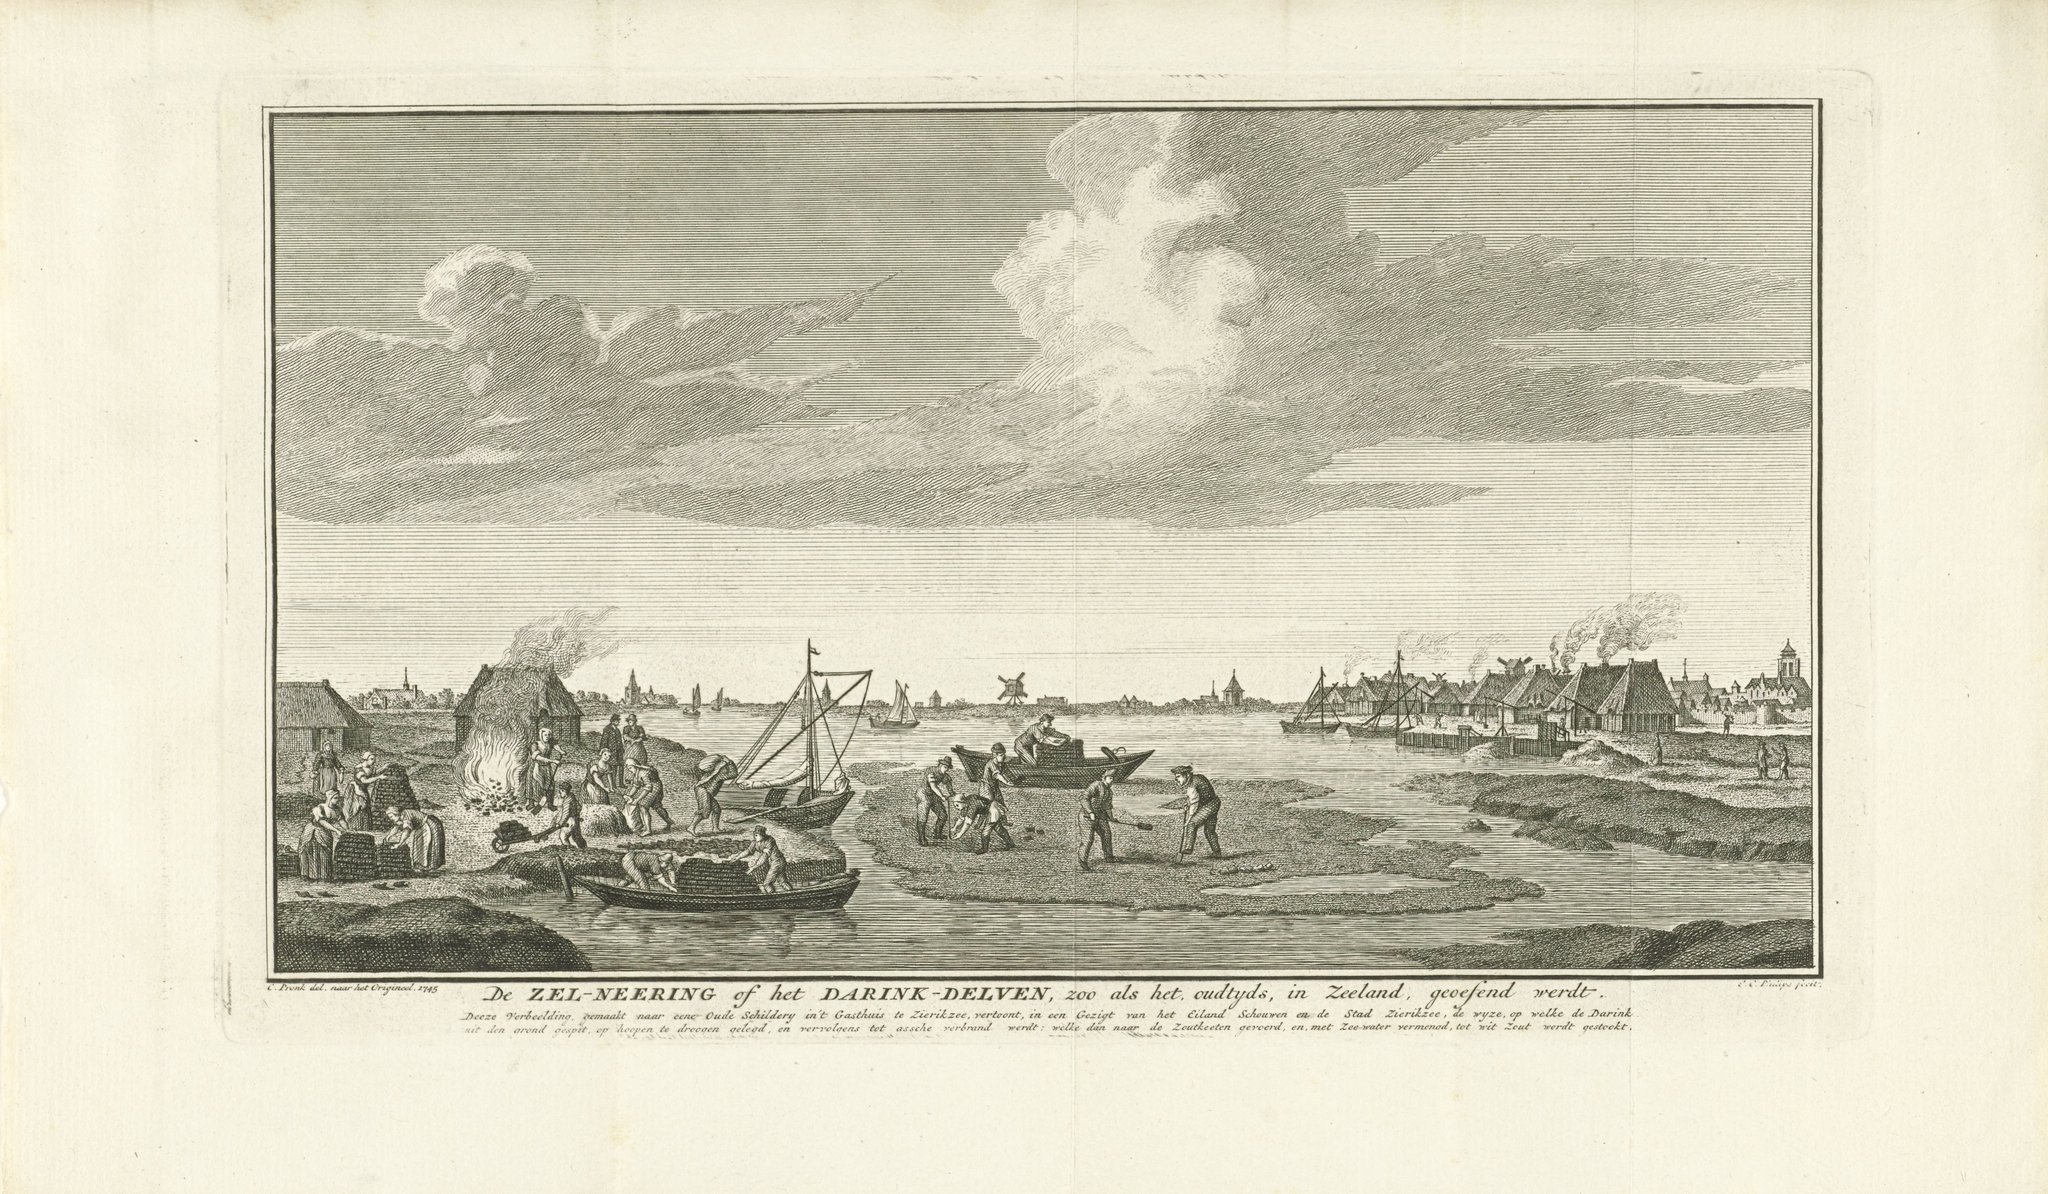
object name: print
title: De zel-neering of het darink-delven, zoo als het oudtyds, in Zeeland, geoefend werdt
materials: paper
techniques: engraving, etching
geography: amsterdam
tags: opencast mine; strip mining, salt, zeeland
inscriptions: collector's mark: Lugt 2228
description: Eerdere staat van prent ook gebruikt in: Wagenaar, Jan. Vaderlandsche historie, vervattende de geschiedenissen der Vereenigde Nederlanden […]. 21 delen. Amsterdam: Isaak Tirion, 1749-1759, dl. 4 (1750), p. 170. En in: Wagenaar, Jan. Vaderlandsche historie, vervattende de geschiedenissen der nu Vereenigde Nederlanden […]. 21 delen. Amsterdam: weduwe Isaak Tirion, 1770, dl. 4, p. 170. Prent naar het anonieme zestiende-eeuwse schilderij op paneel in de Burgemeesterskamer van het oude stadhuis van Zierikzee.